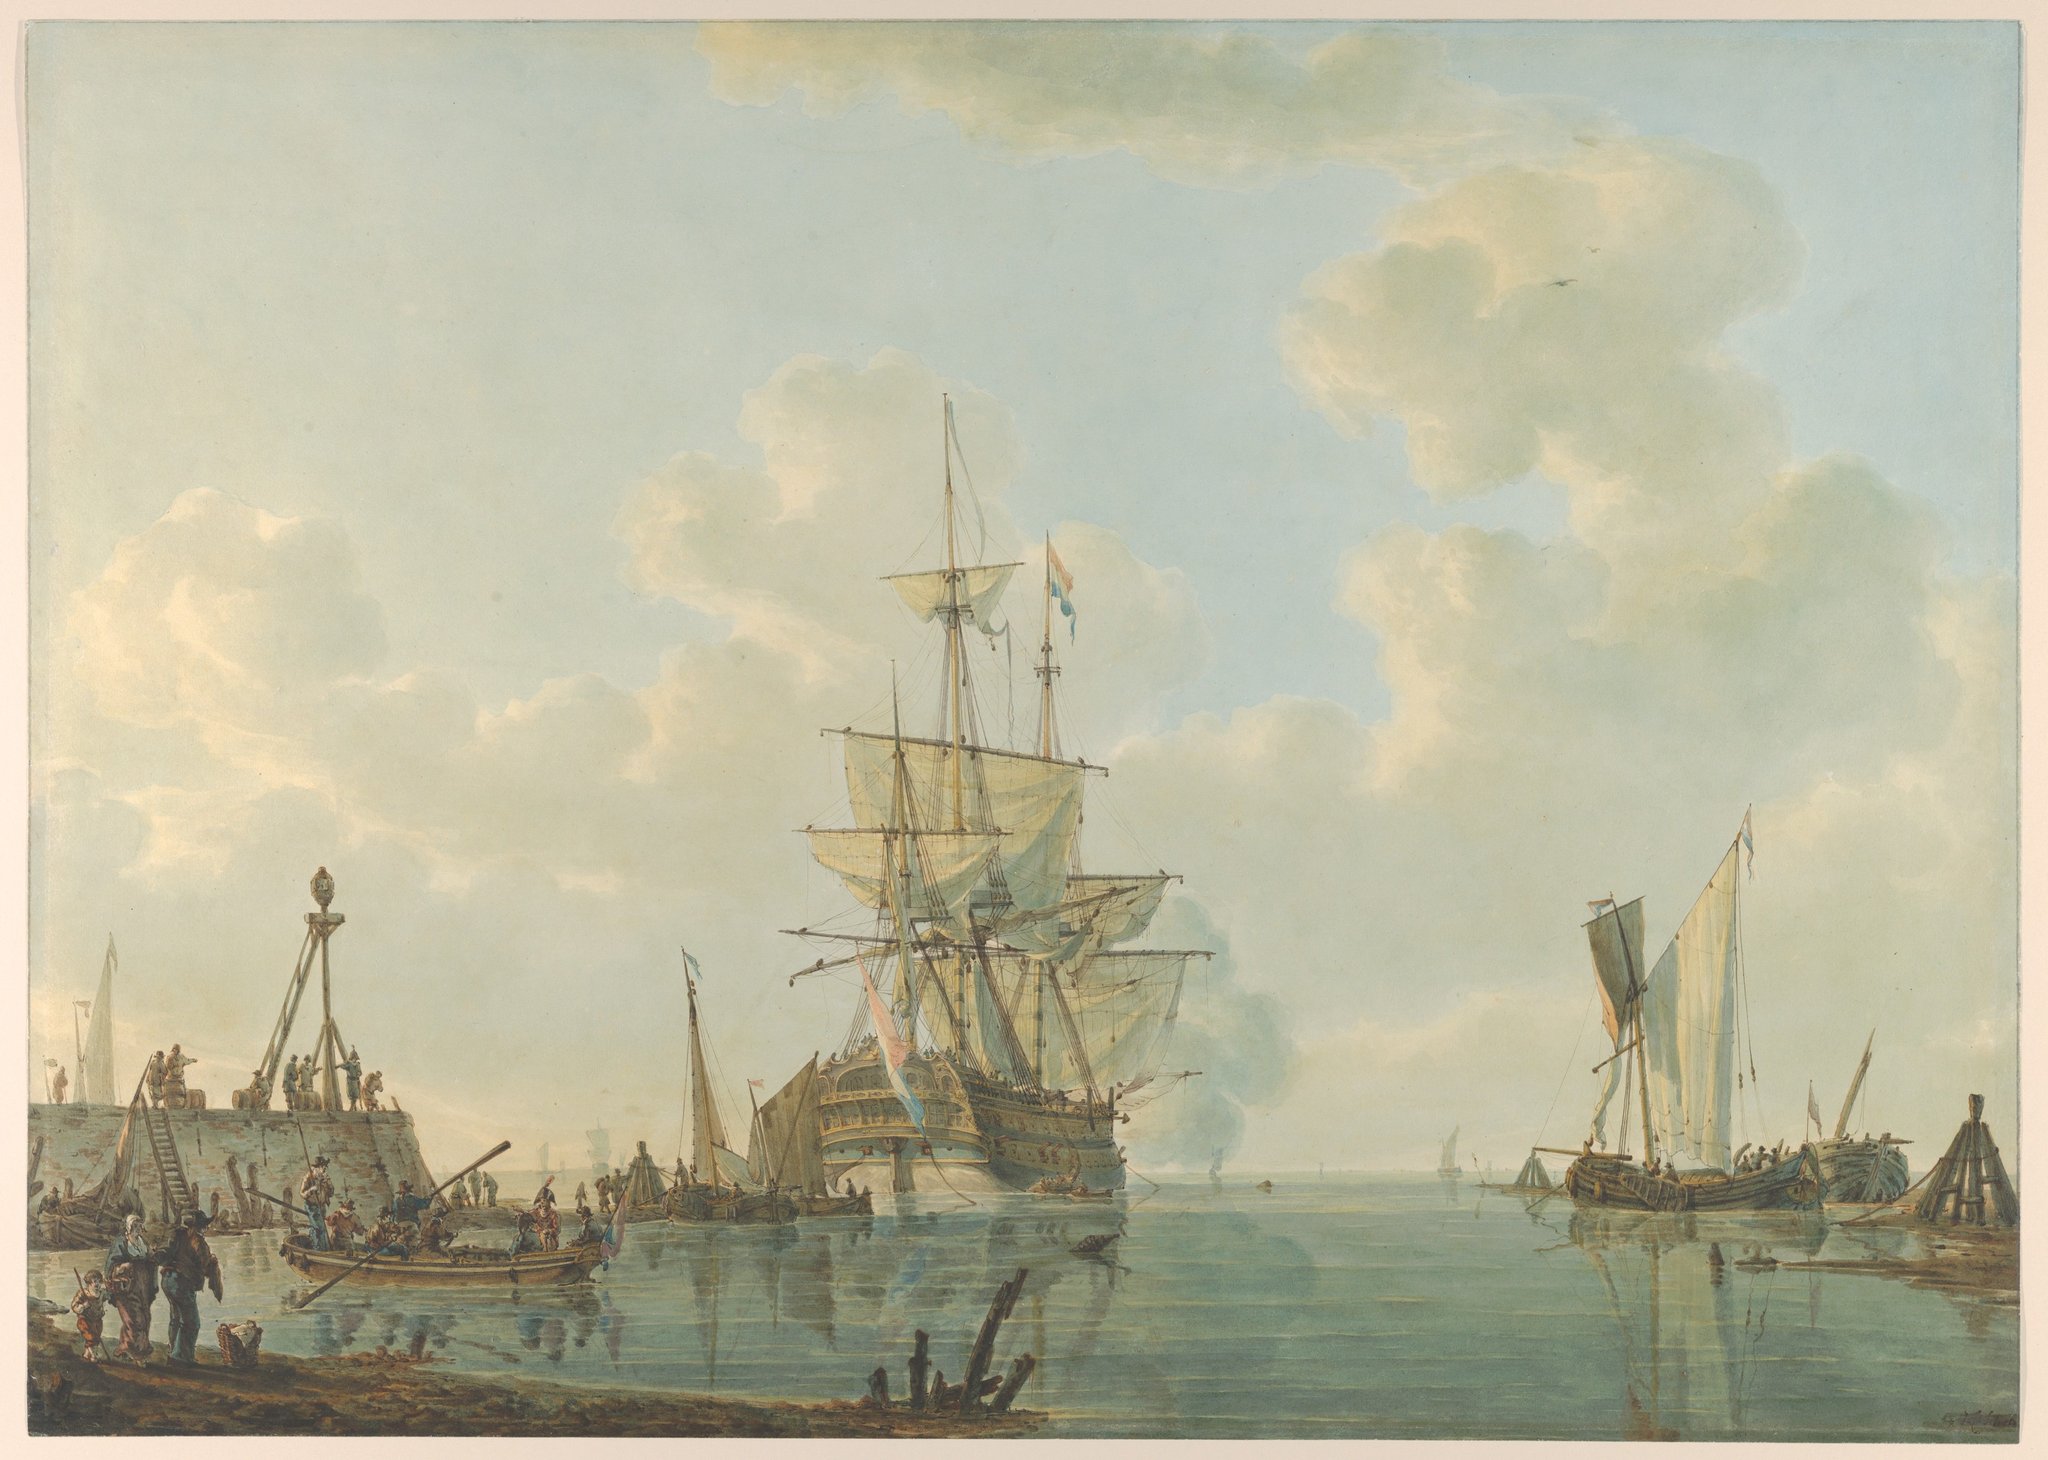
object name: drawing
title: A Man O'War Lying at Anchor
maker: johannes christiaan schotel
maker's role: artist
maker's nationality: dutch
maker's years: 1787-1838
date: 1801-1833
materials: graphite, ink, watercolor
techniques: pen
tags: soldiers,men,boats,ships